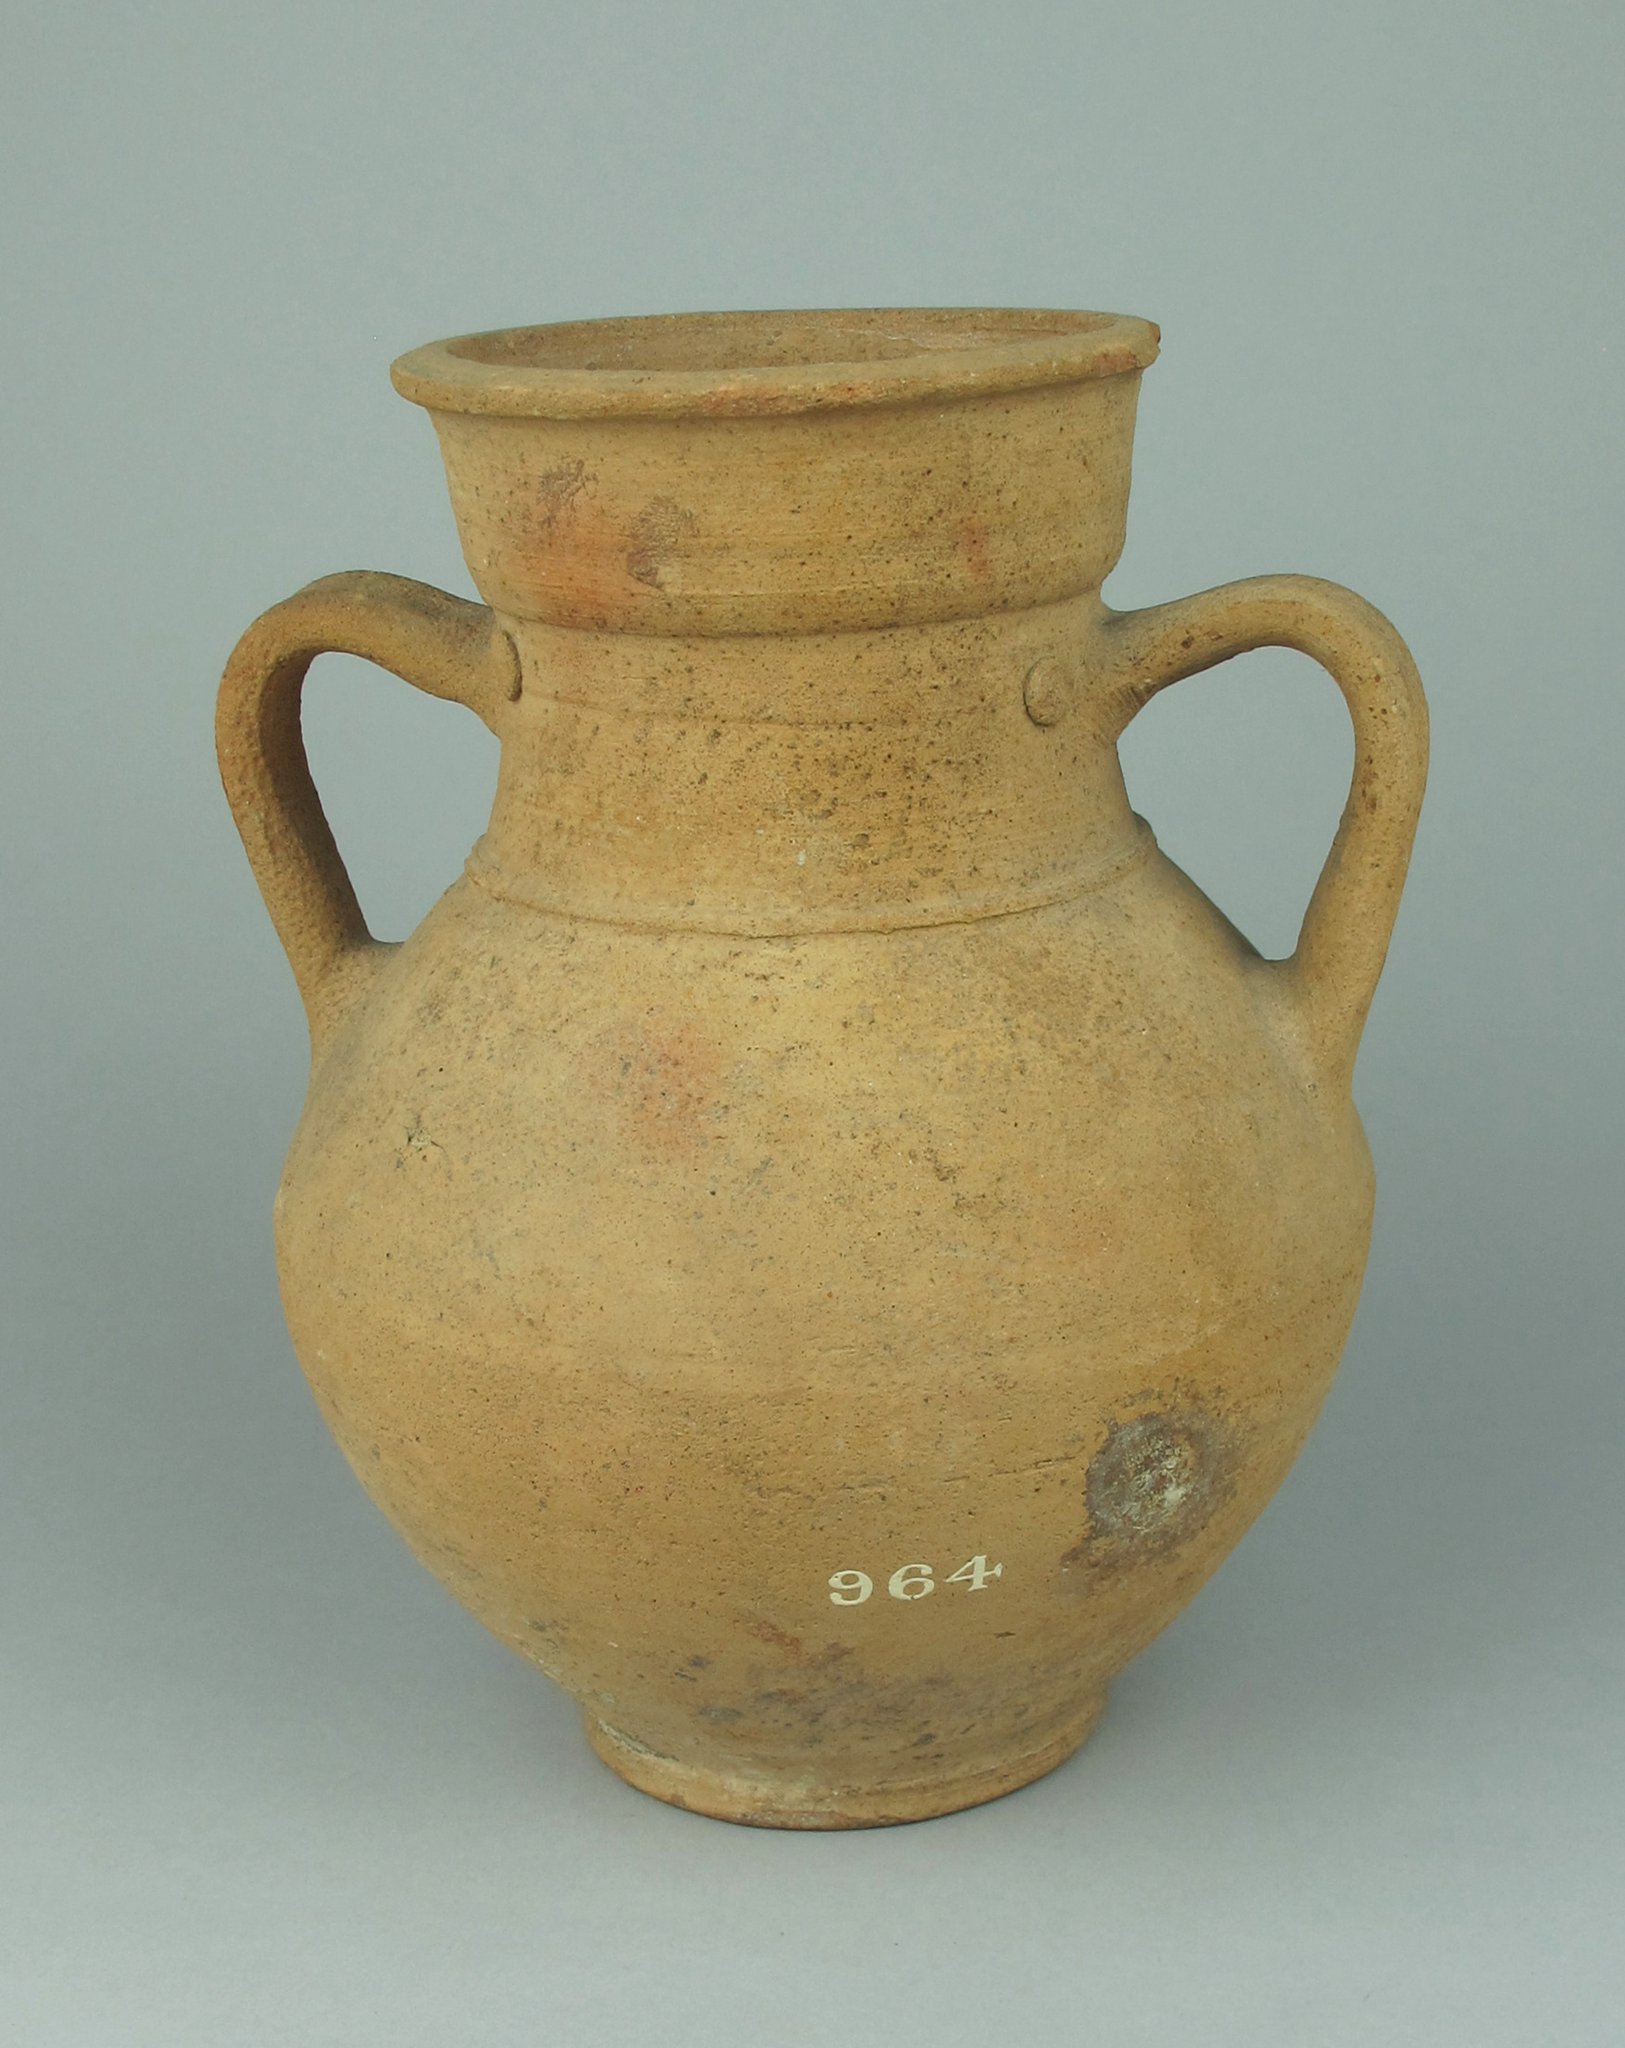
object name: amphora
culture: cypriot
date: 3900 BCE-100 CE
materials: terracotta